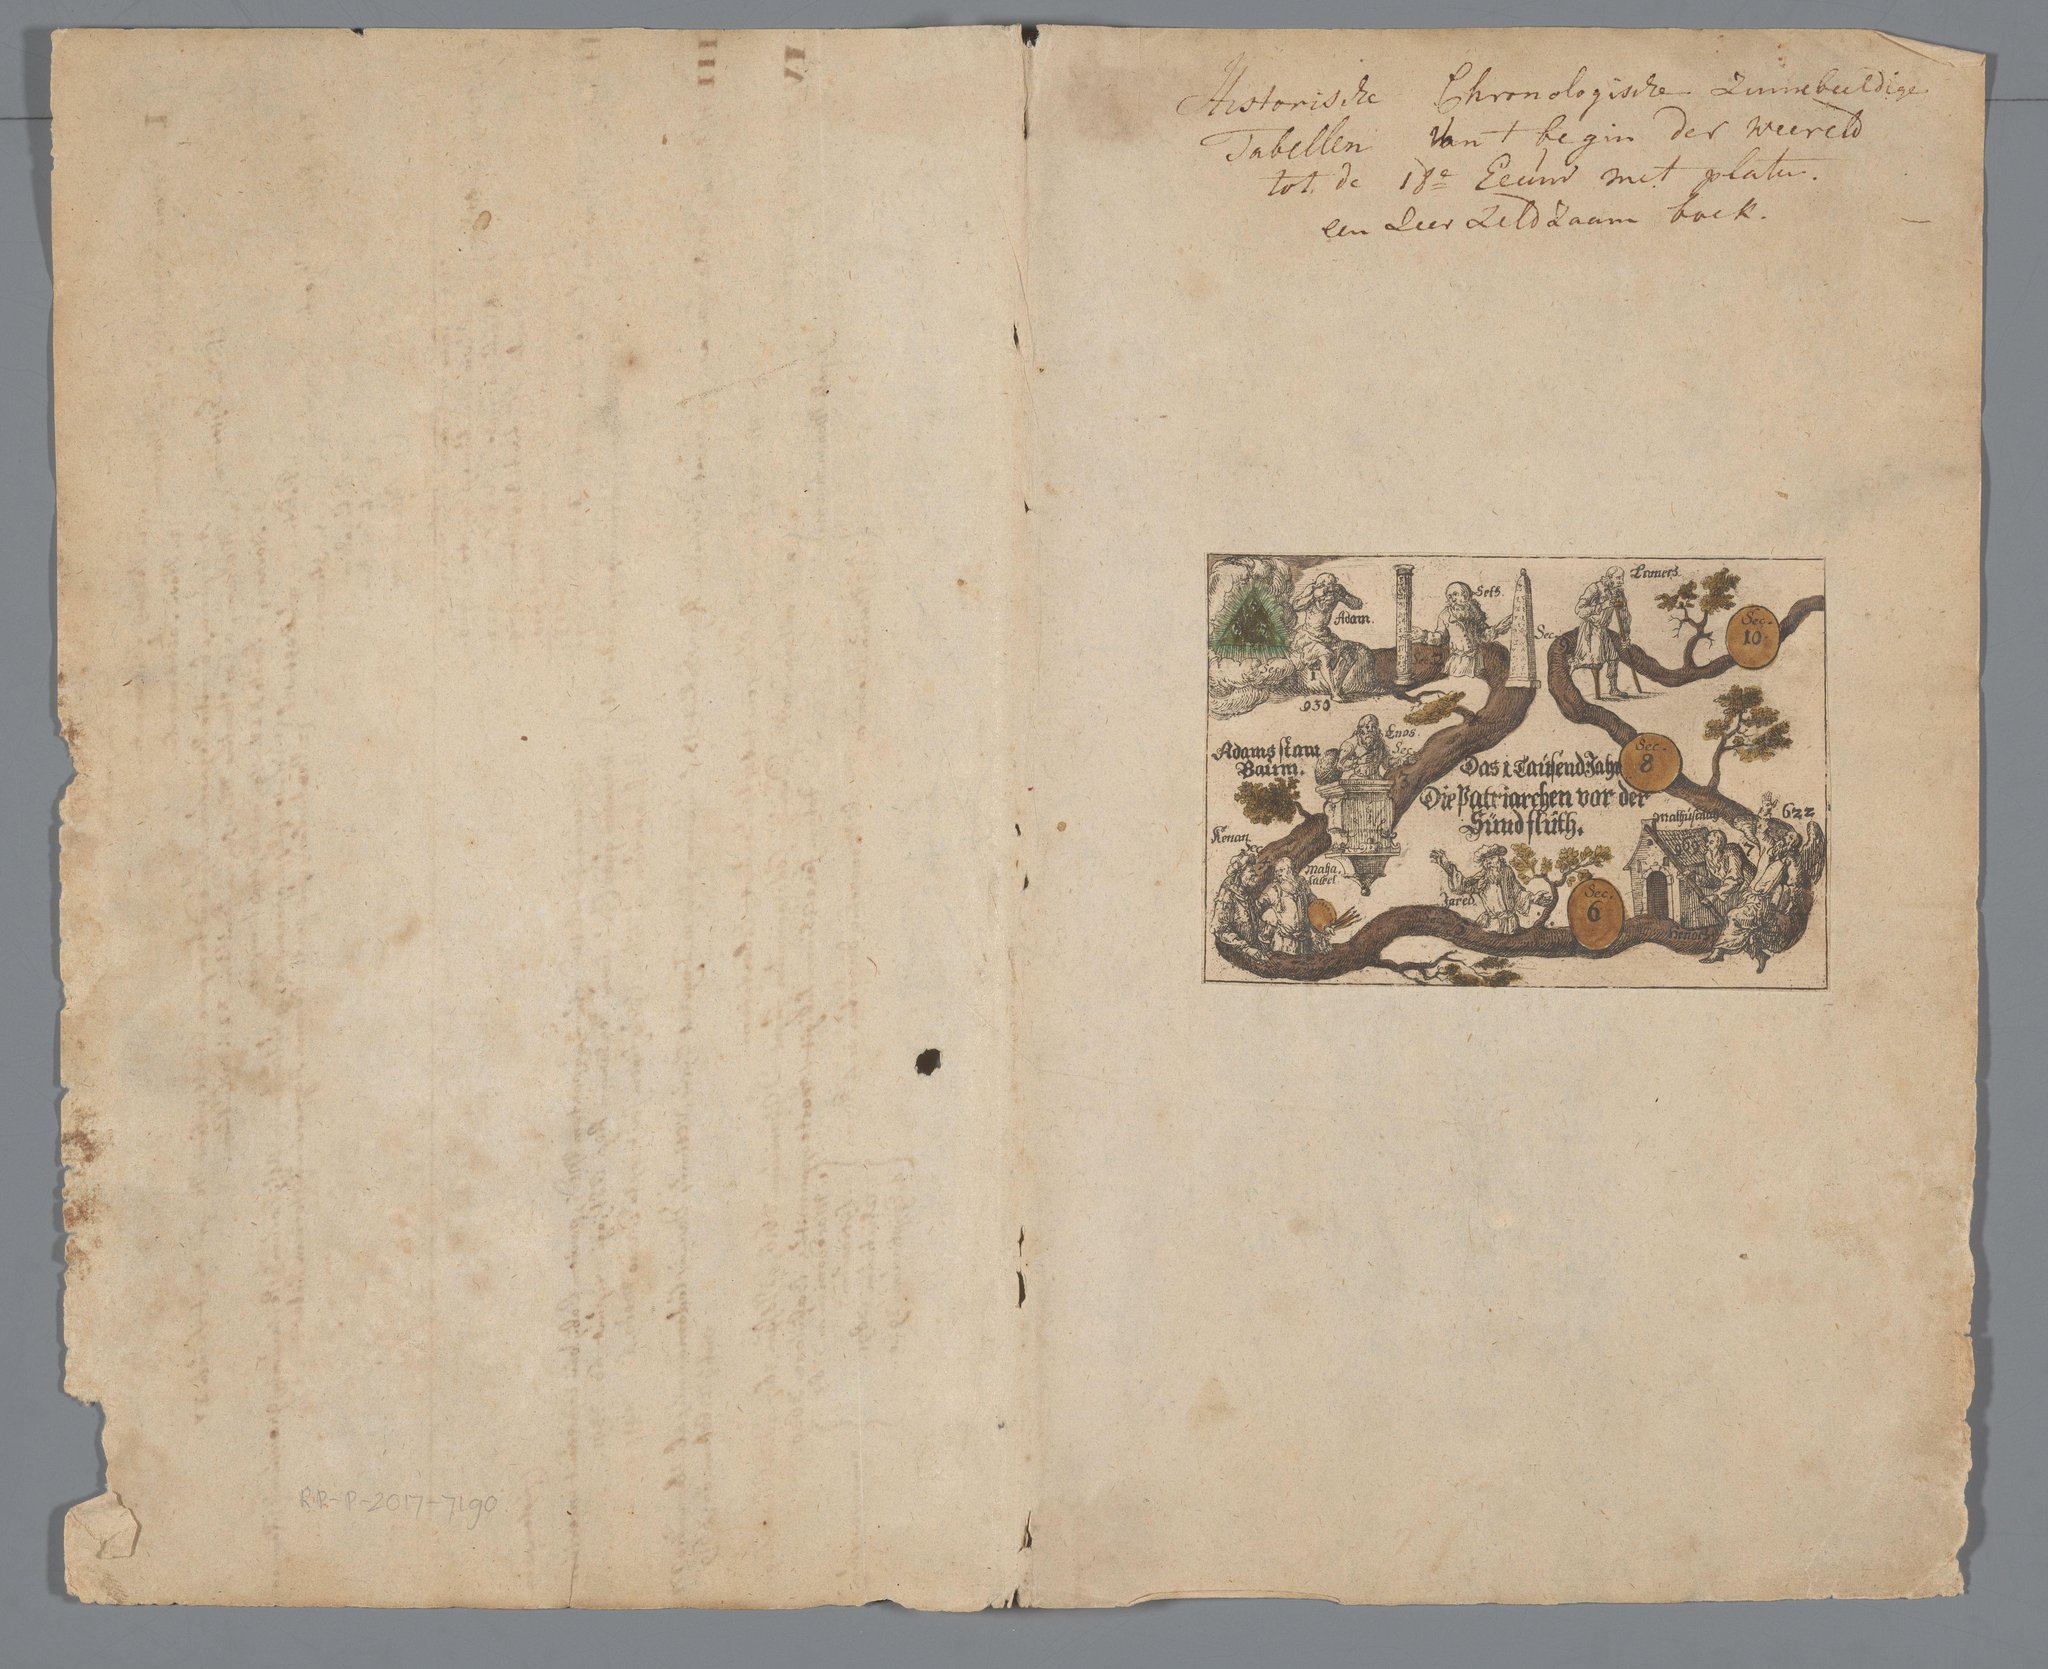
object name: print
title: Historische Bilder/ Darinnen Idea Historiae Universalis : Eine kurtze Summarische Abbildung Der fürnehmsten Geist- und Weltlichen Geschichte durch die vier Monarchien ..., door Johannes Buno, Lüneburg: B. Elers, 1672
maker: Anonymous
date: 1667-1672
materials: paper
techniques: etching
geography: germany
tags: historical events and situations; historical persons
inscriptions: collector's mark: Lugt 2166, annotation: ‘Historische Chronologische Zinnebeeldige Tabellen van t begn der weereld tot de 18e Eeuw met platen. een zeer zeldzaam boek.’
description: Prentalbum samengesteld uit 21 prenten geknipt uit het werk van Johannes Buno van 1672, opgeplakt op dubbelgevouwen bladen papier. Enkele prenten los. Op de laatste bladzijden een handgeschreven tijdschema in het Latijn. Het werk geeft een historische overzicht van de geschiedenis van de wereld in millenia en eeuwen, volgens mnemotechniek of geheugenkunst.